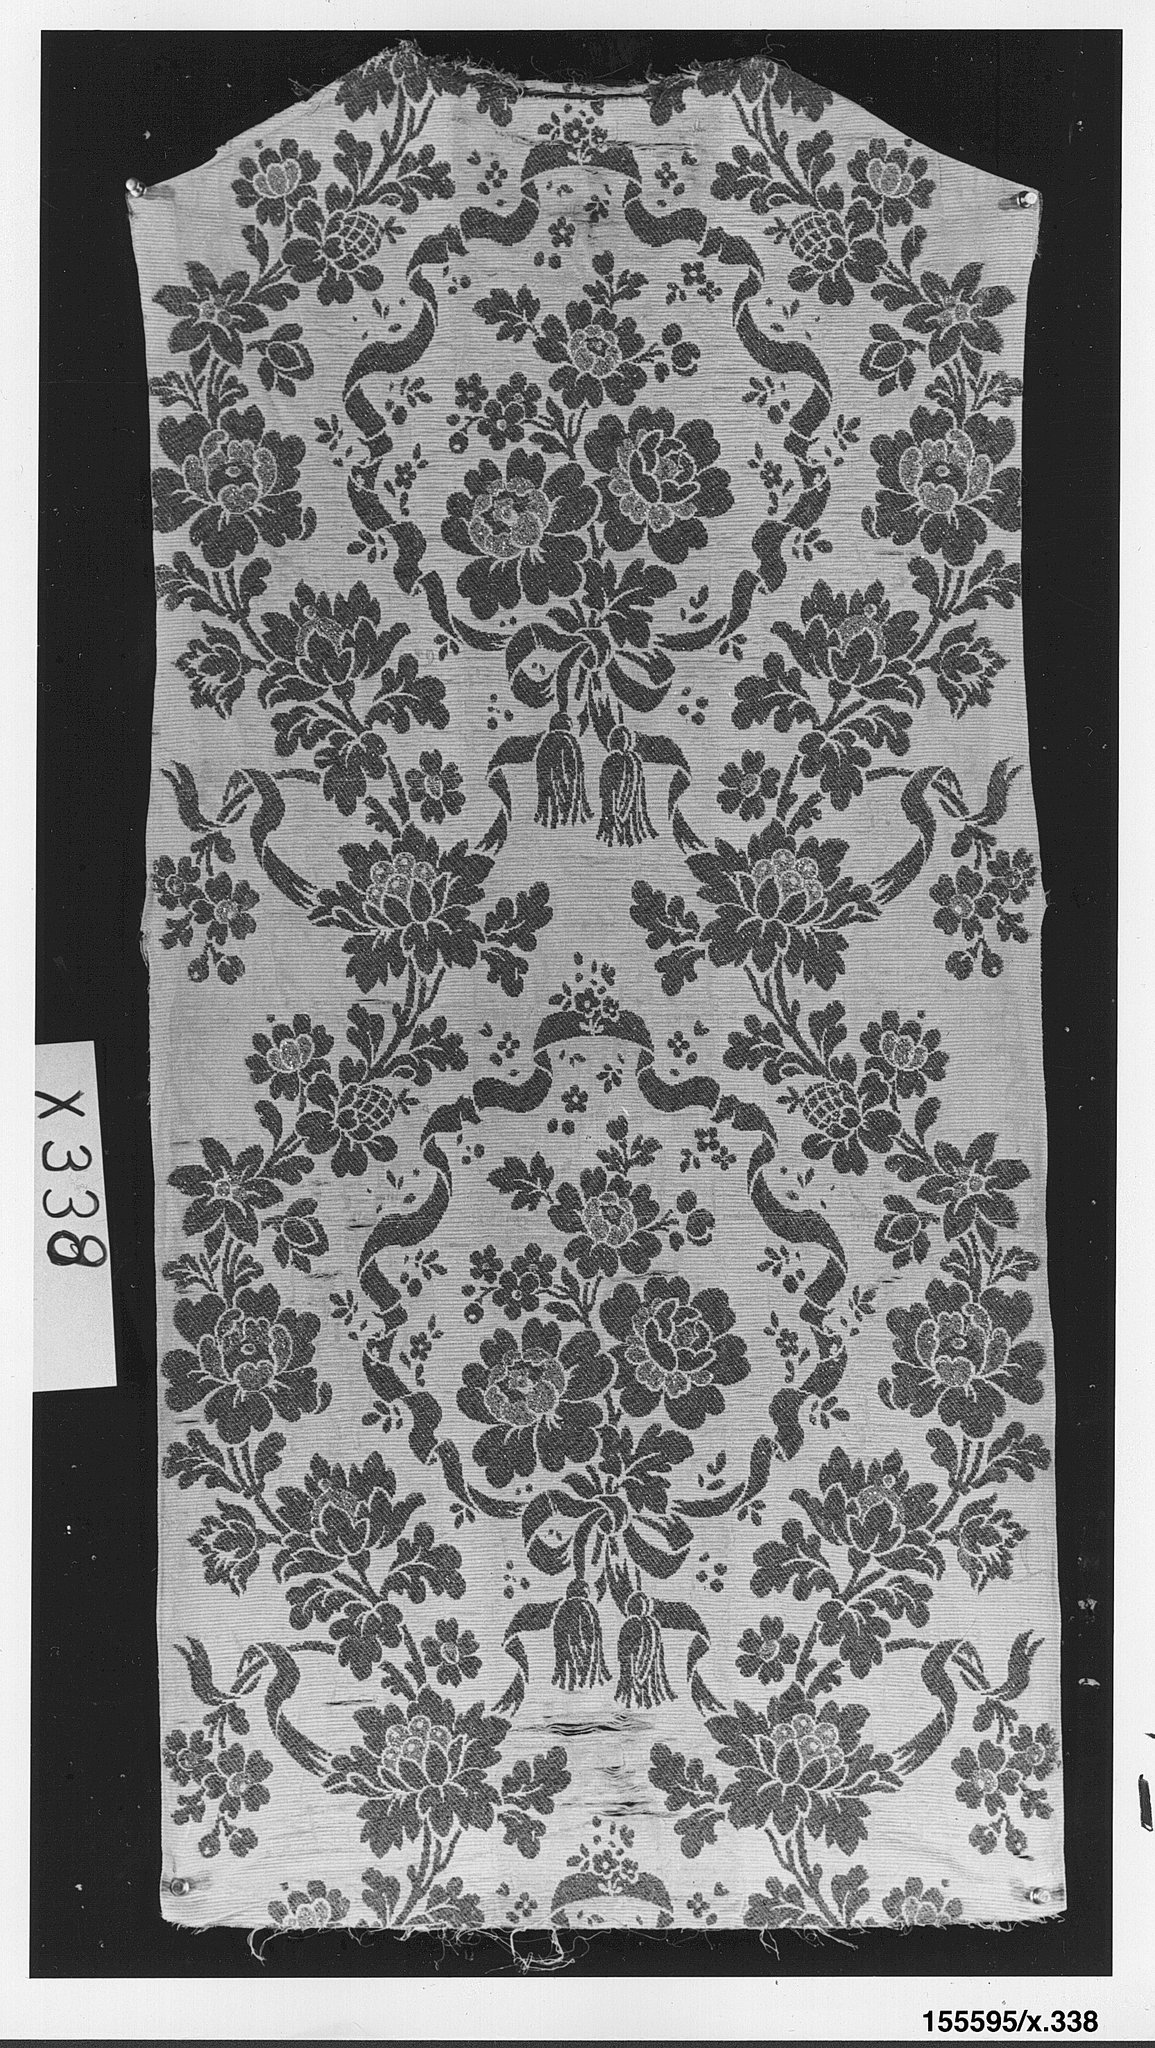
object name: piece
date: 1780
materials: metal thread, silk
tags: flowers,leaves